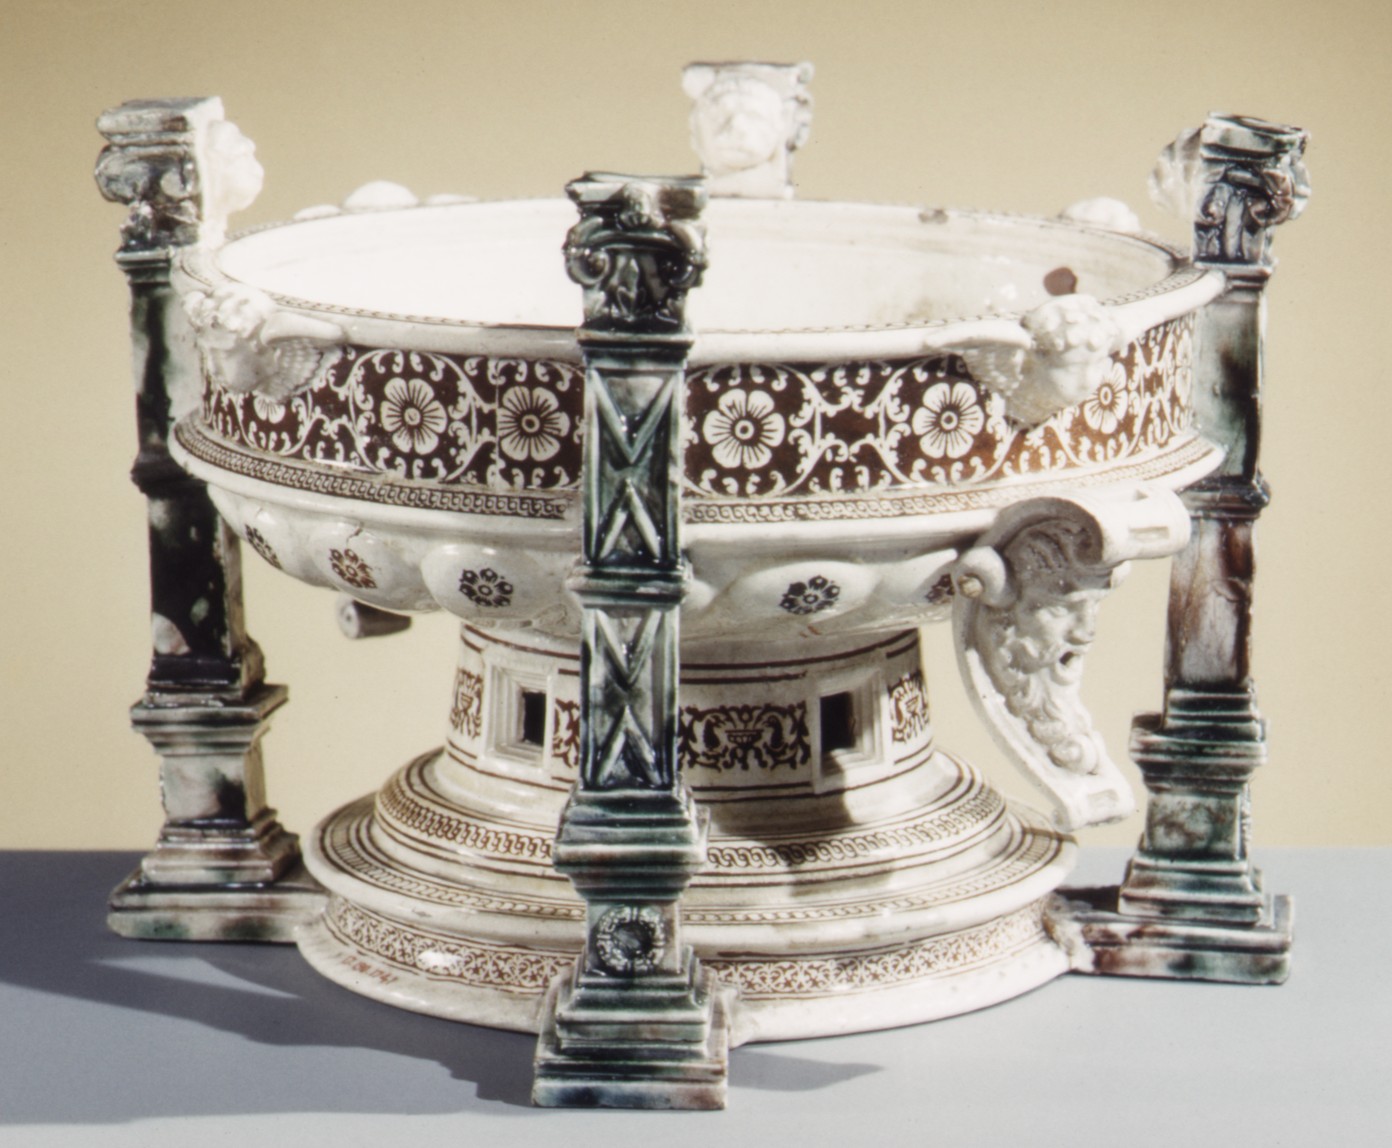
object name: basin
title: Basin (Réchaud)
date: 1534-1566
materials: earthenware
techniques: glazing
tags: faces,flowers